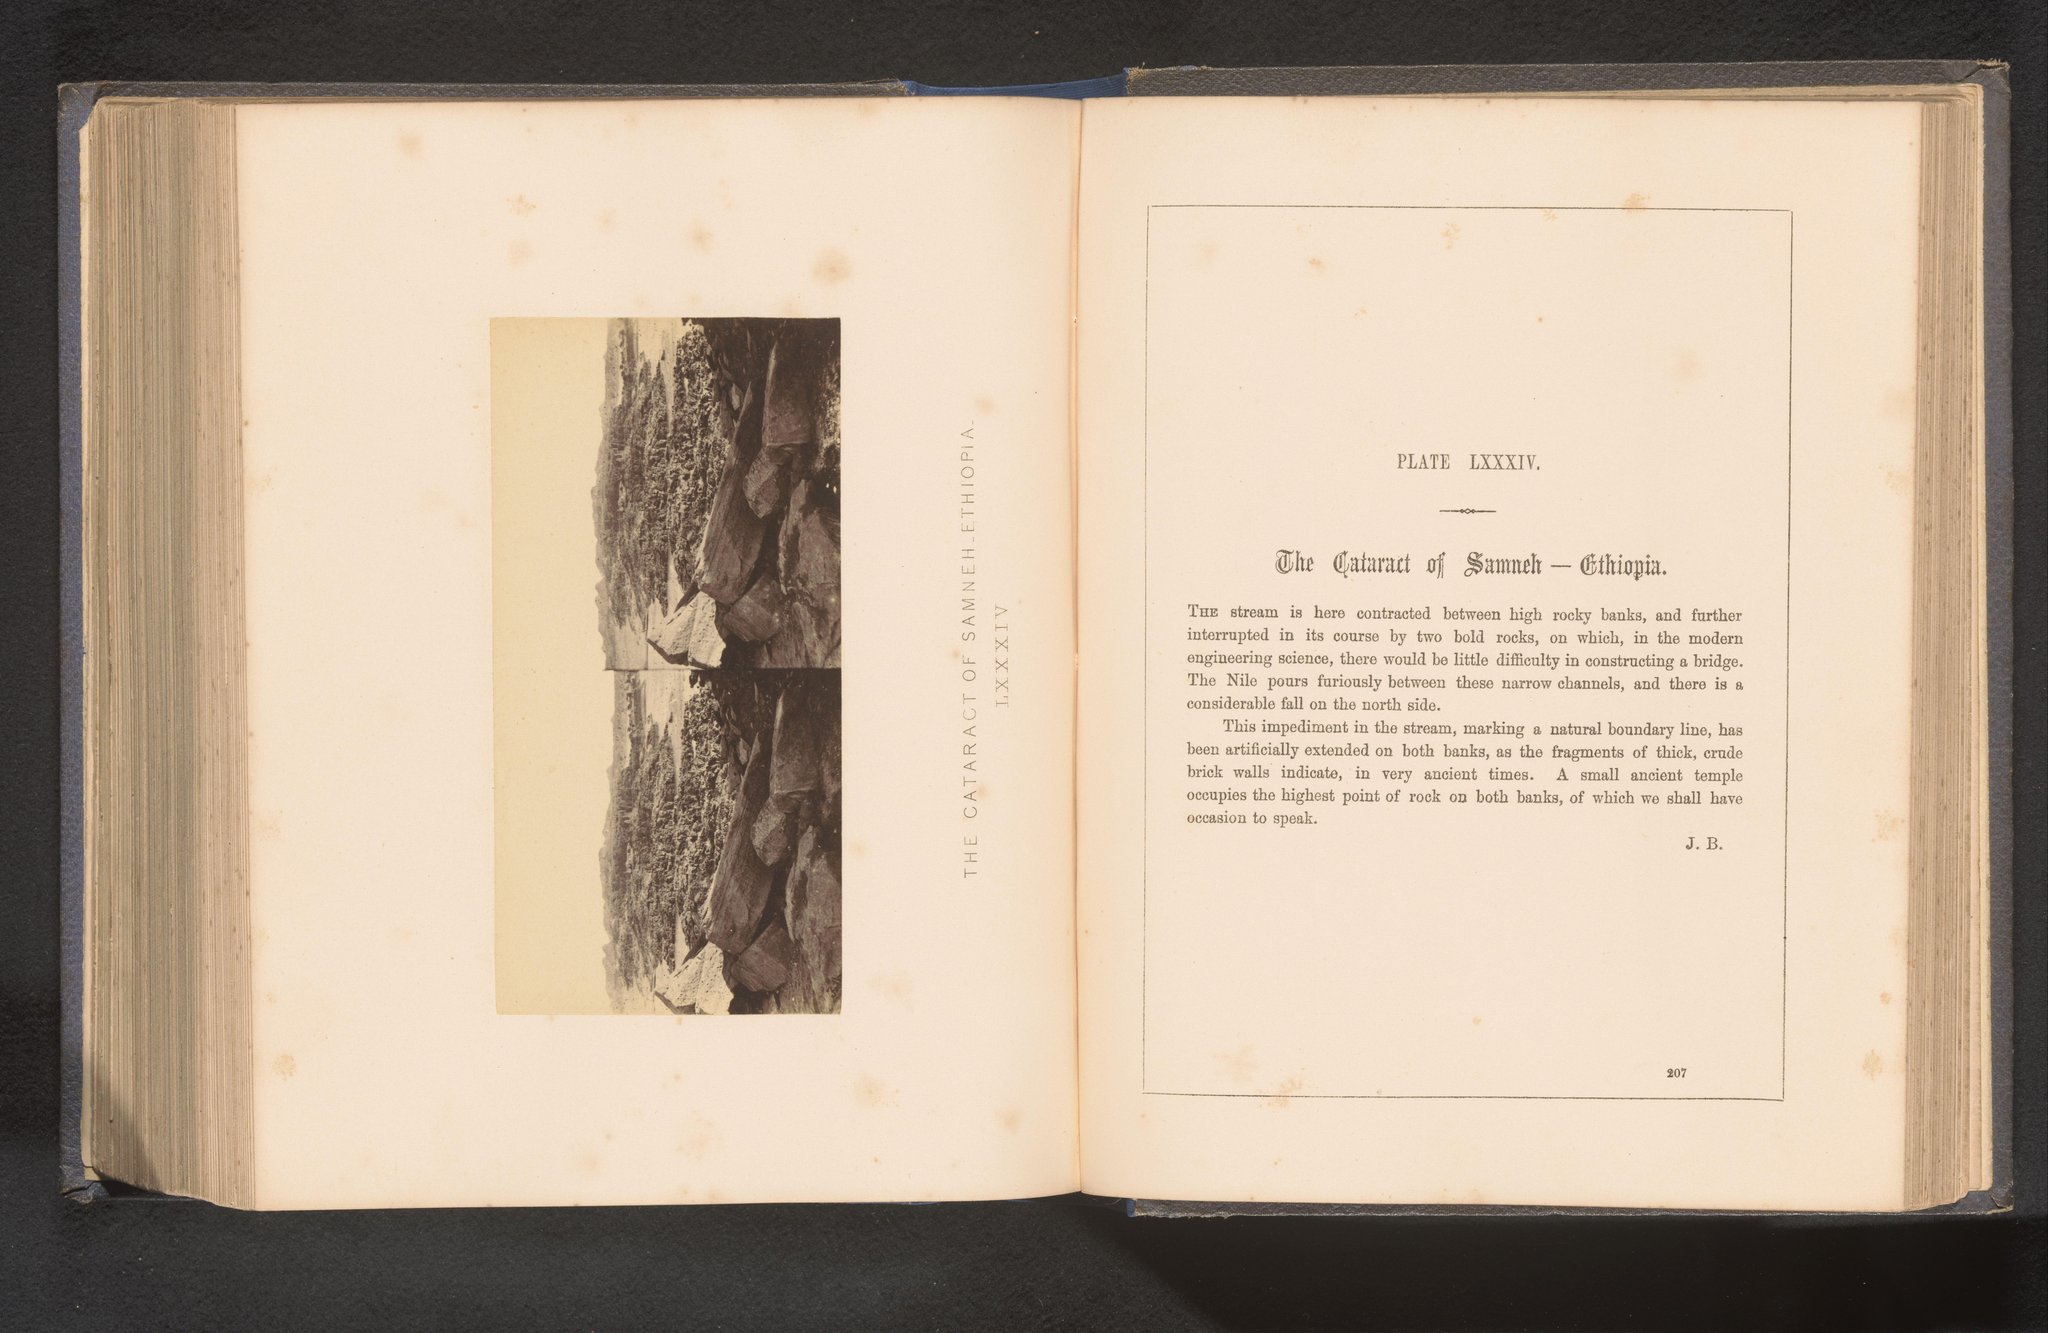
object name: page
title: The cataract of Samneh - Ethiopia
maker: francis frith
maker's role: publisher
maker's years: 1822-1898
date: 1857-1862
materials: photographic support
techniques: albumen print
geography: semna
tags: landscapes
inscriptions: number: ‘LXXXIV’, name: ‘Frith’